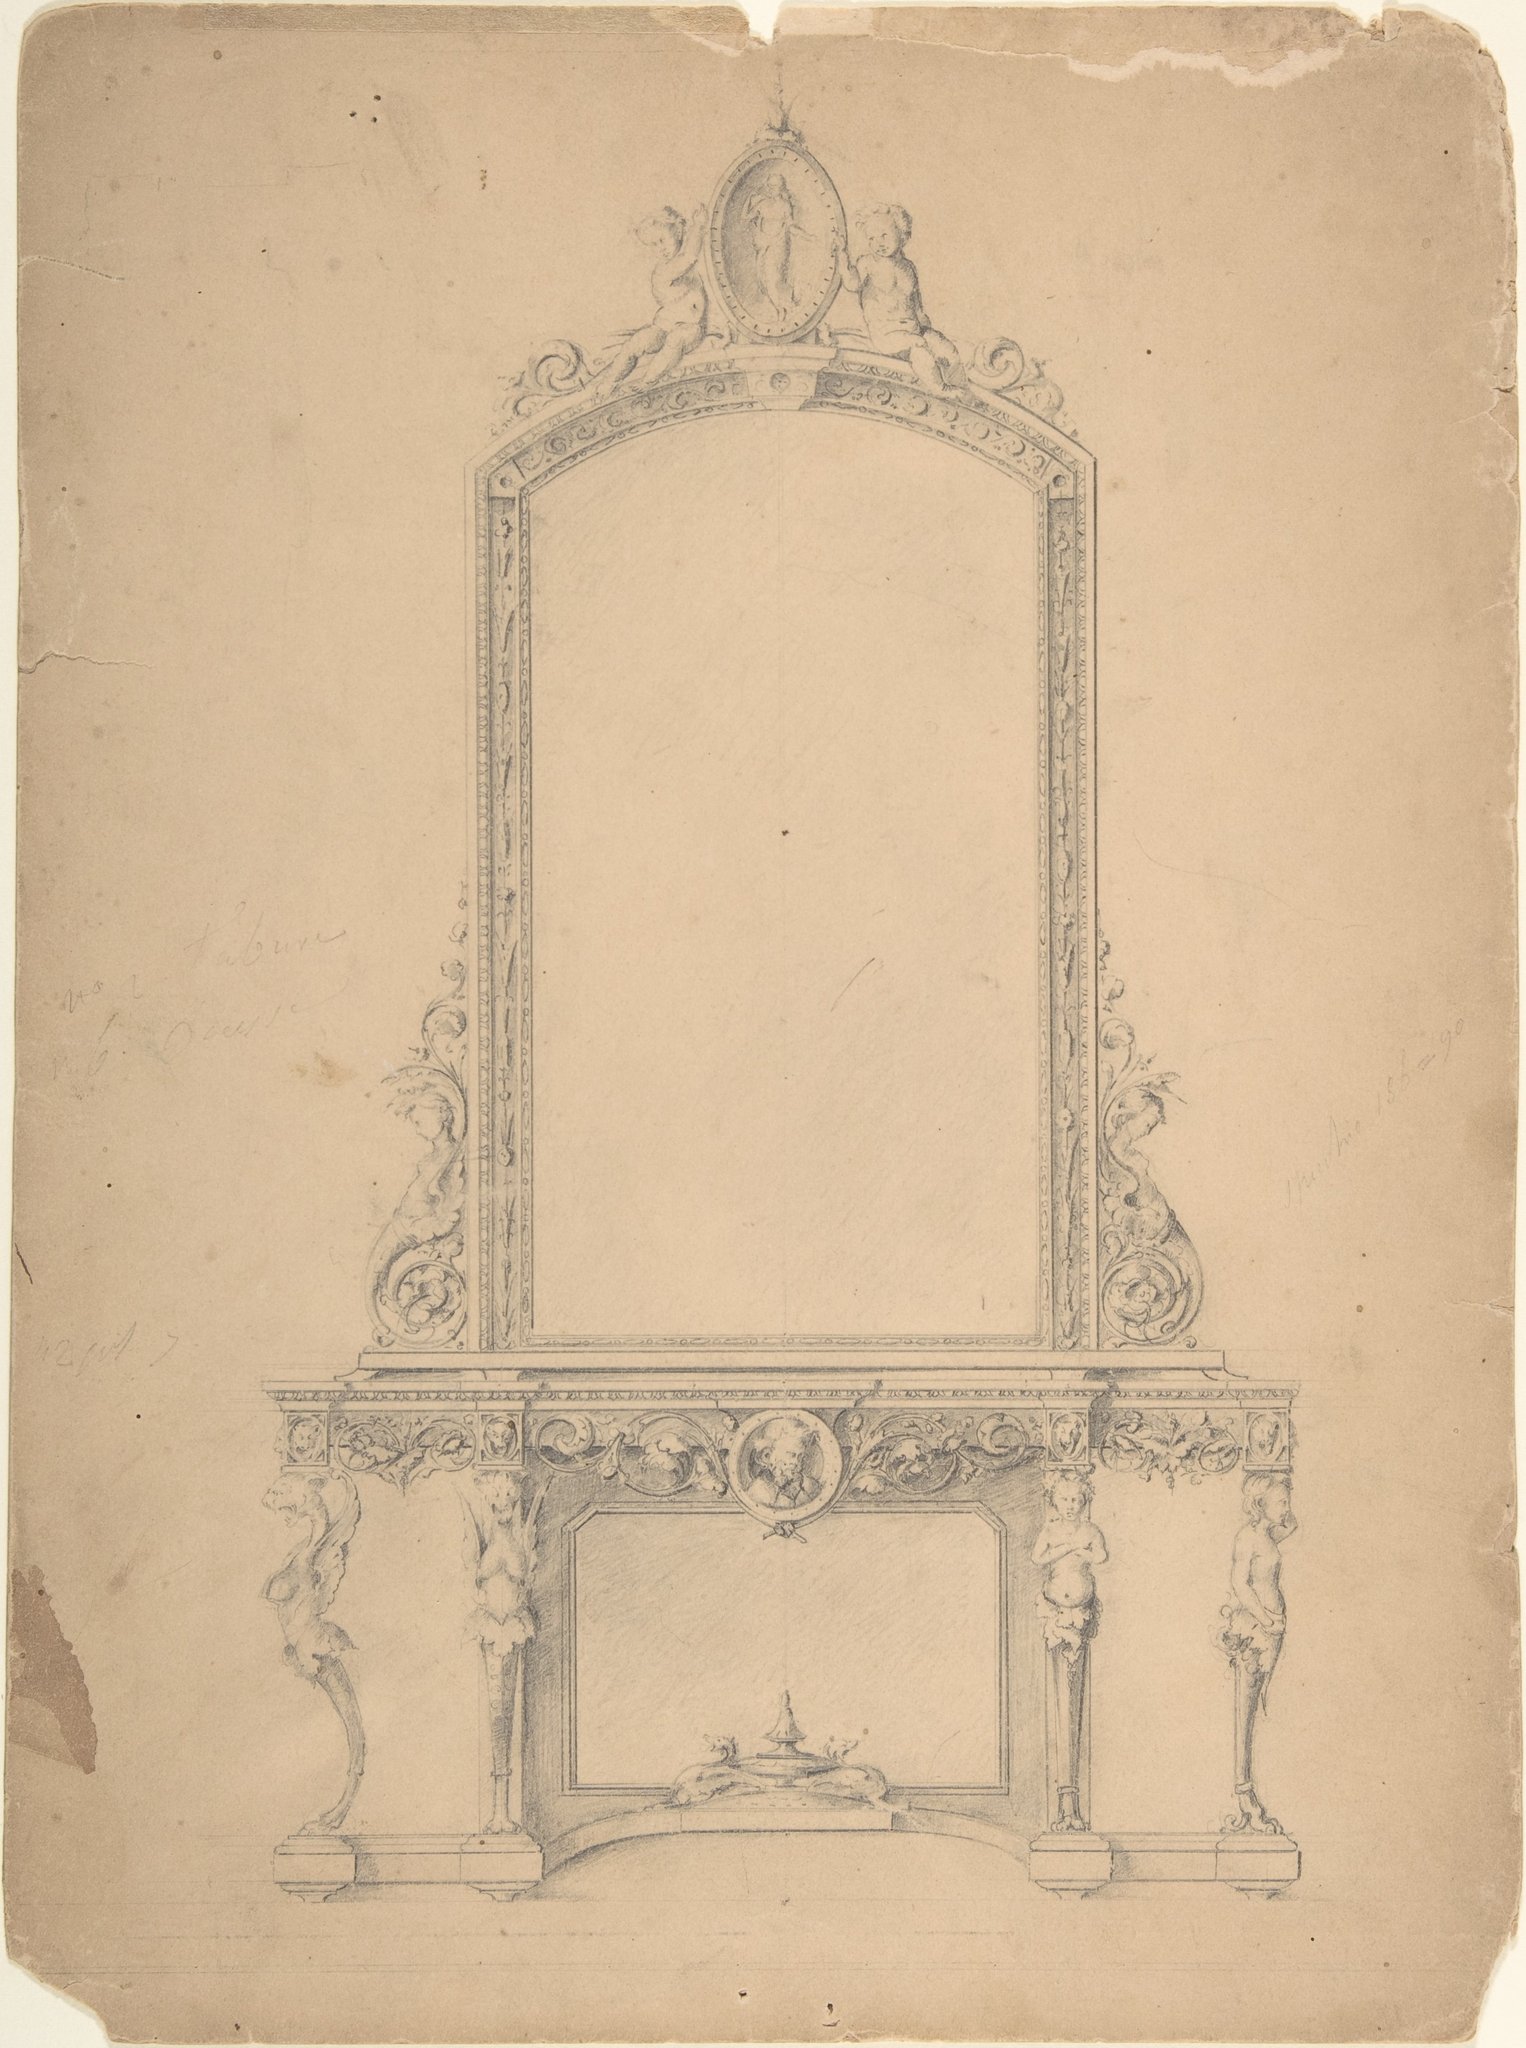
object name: drawing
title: Design for a Mirror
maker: anonymous, italian, 19th century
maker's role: artist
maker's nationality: italian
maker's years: 1800-1900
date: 1800-1900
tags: caryatids,mirrors